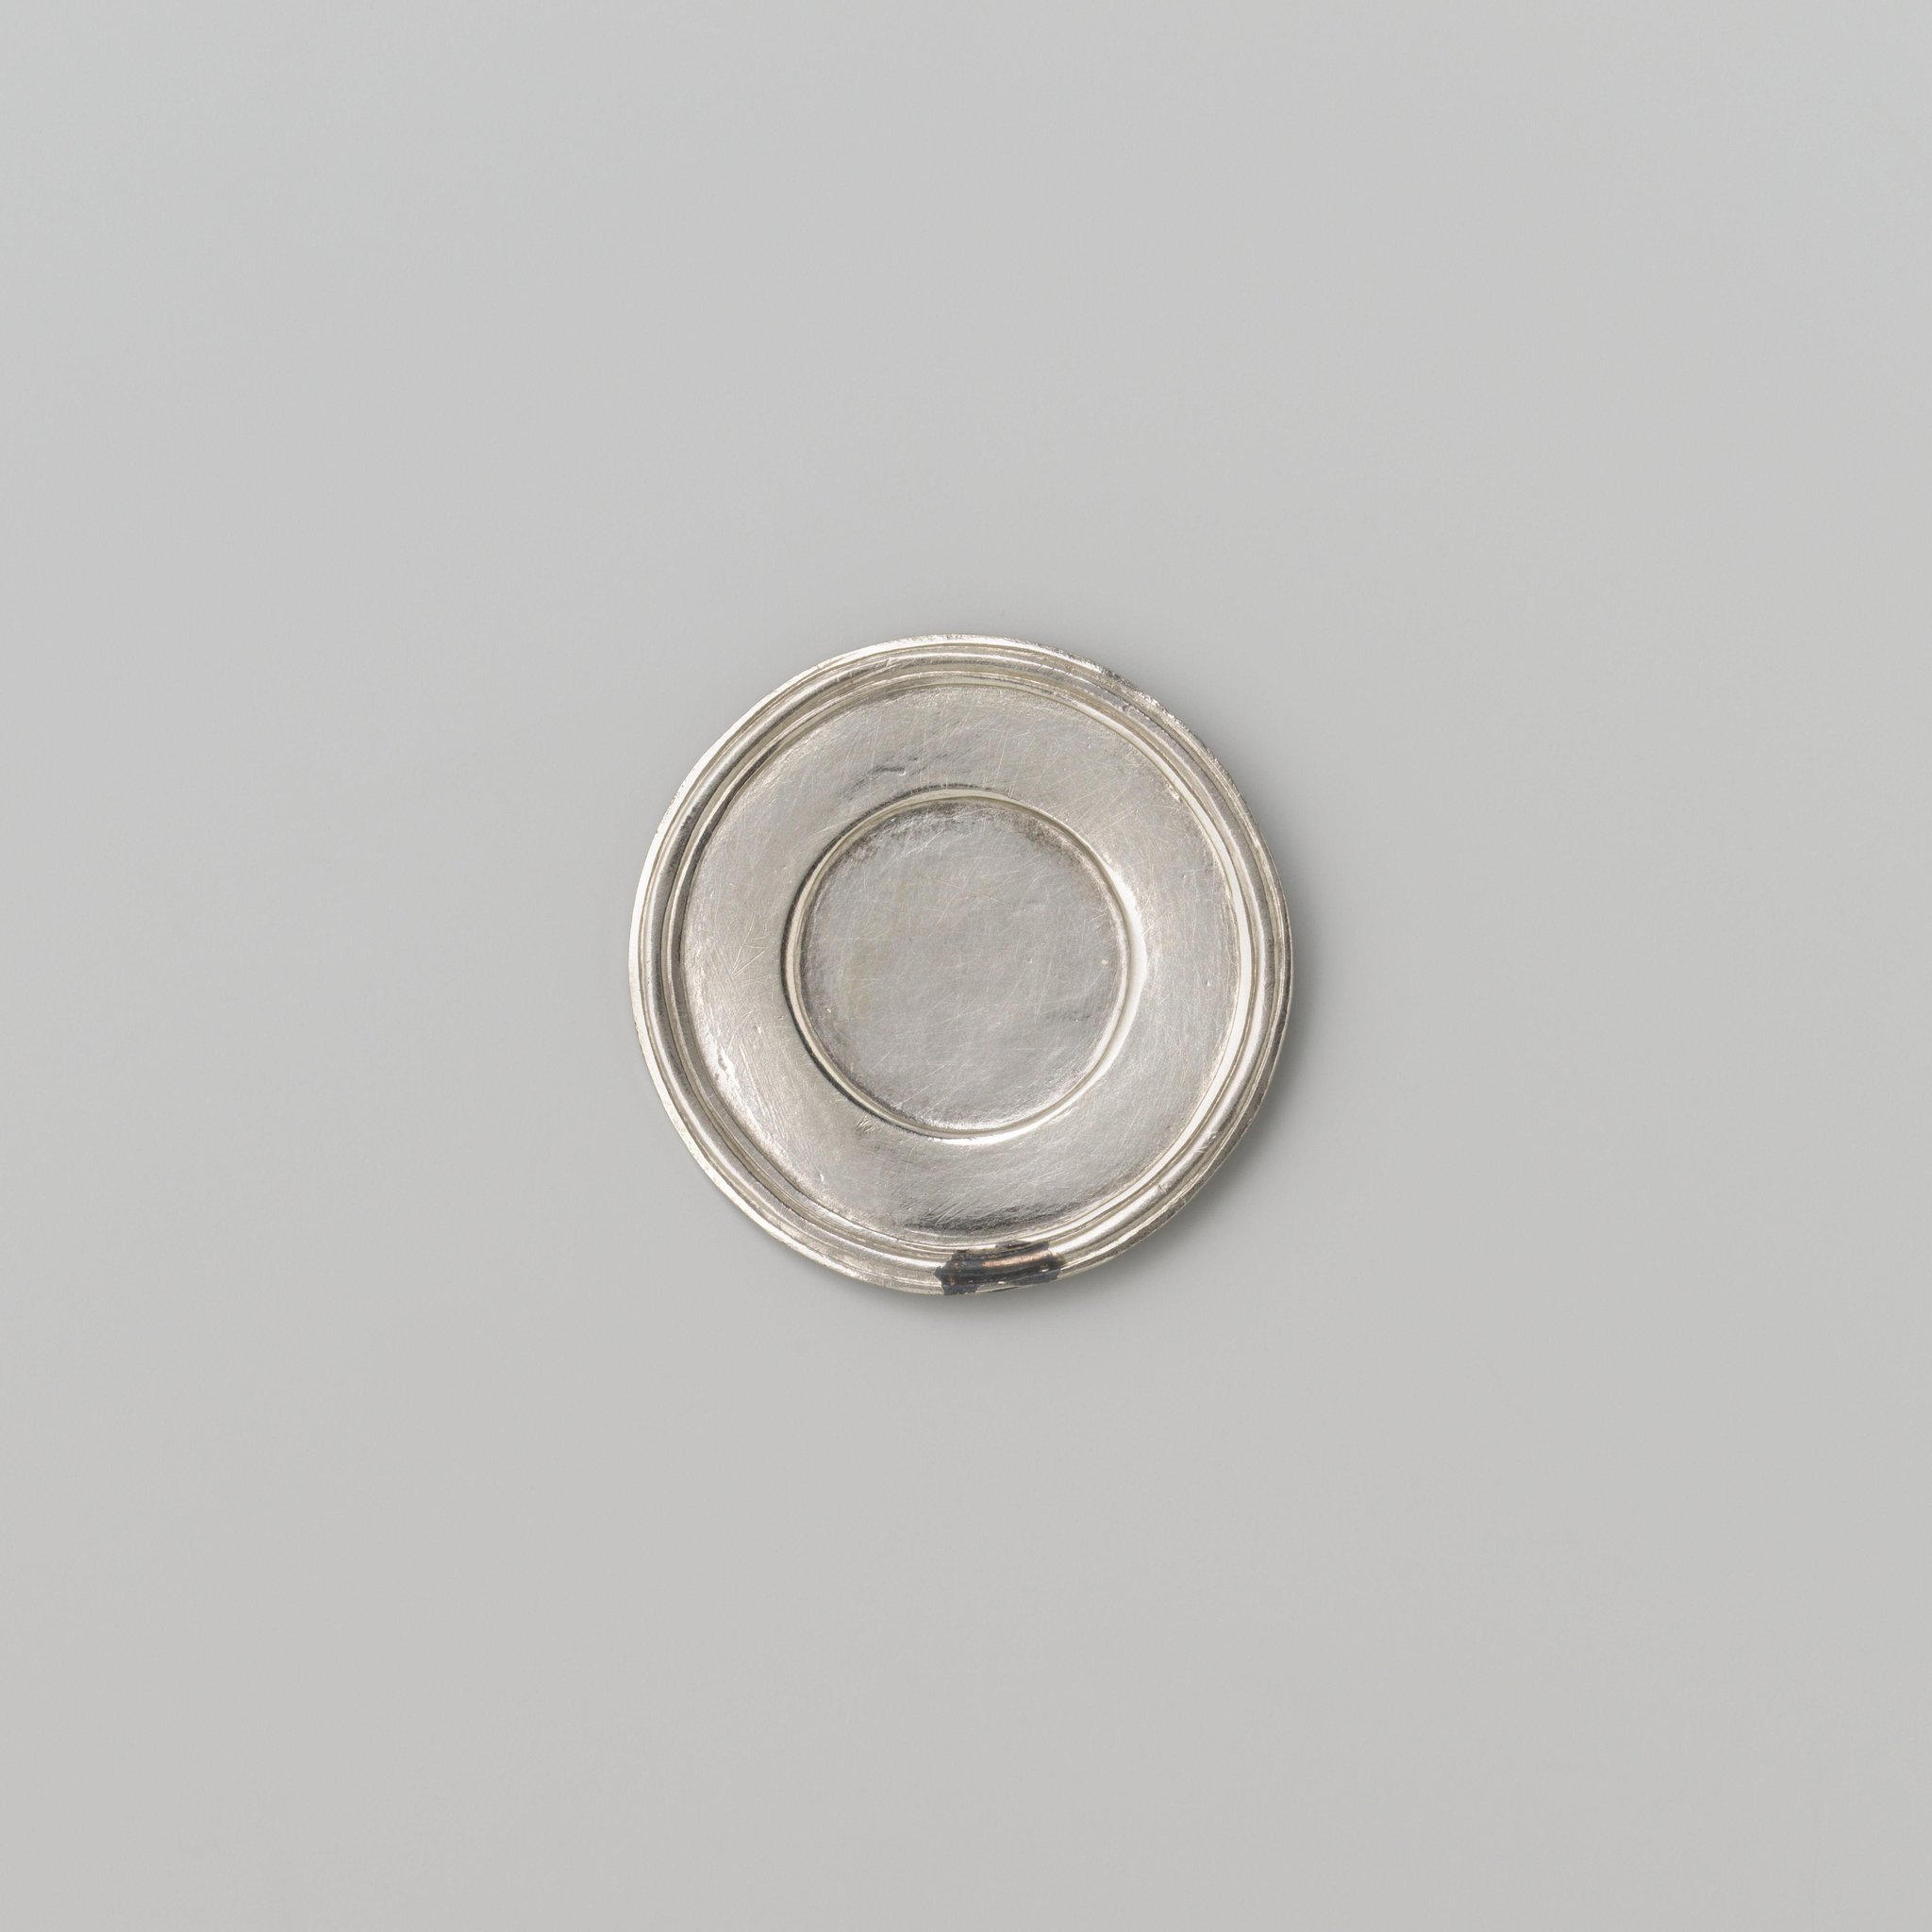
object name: miniature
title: Zilverkleurige schoteltje met brede platte geprofileerde rand.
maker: Anonymous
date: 1700-1710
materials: copper alloy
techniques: silvering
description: Zilverkleurige schotel met brede, platte geprofileerde rand.